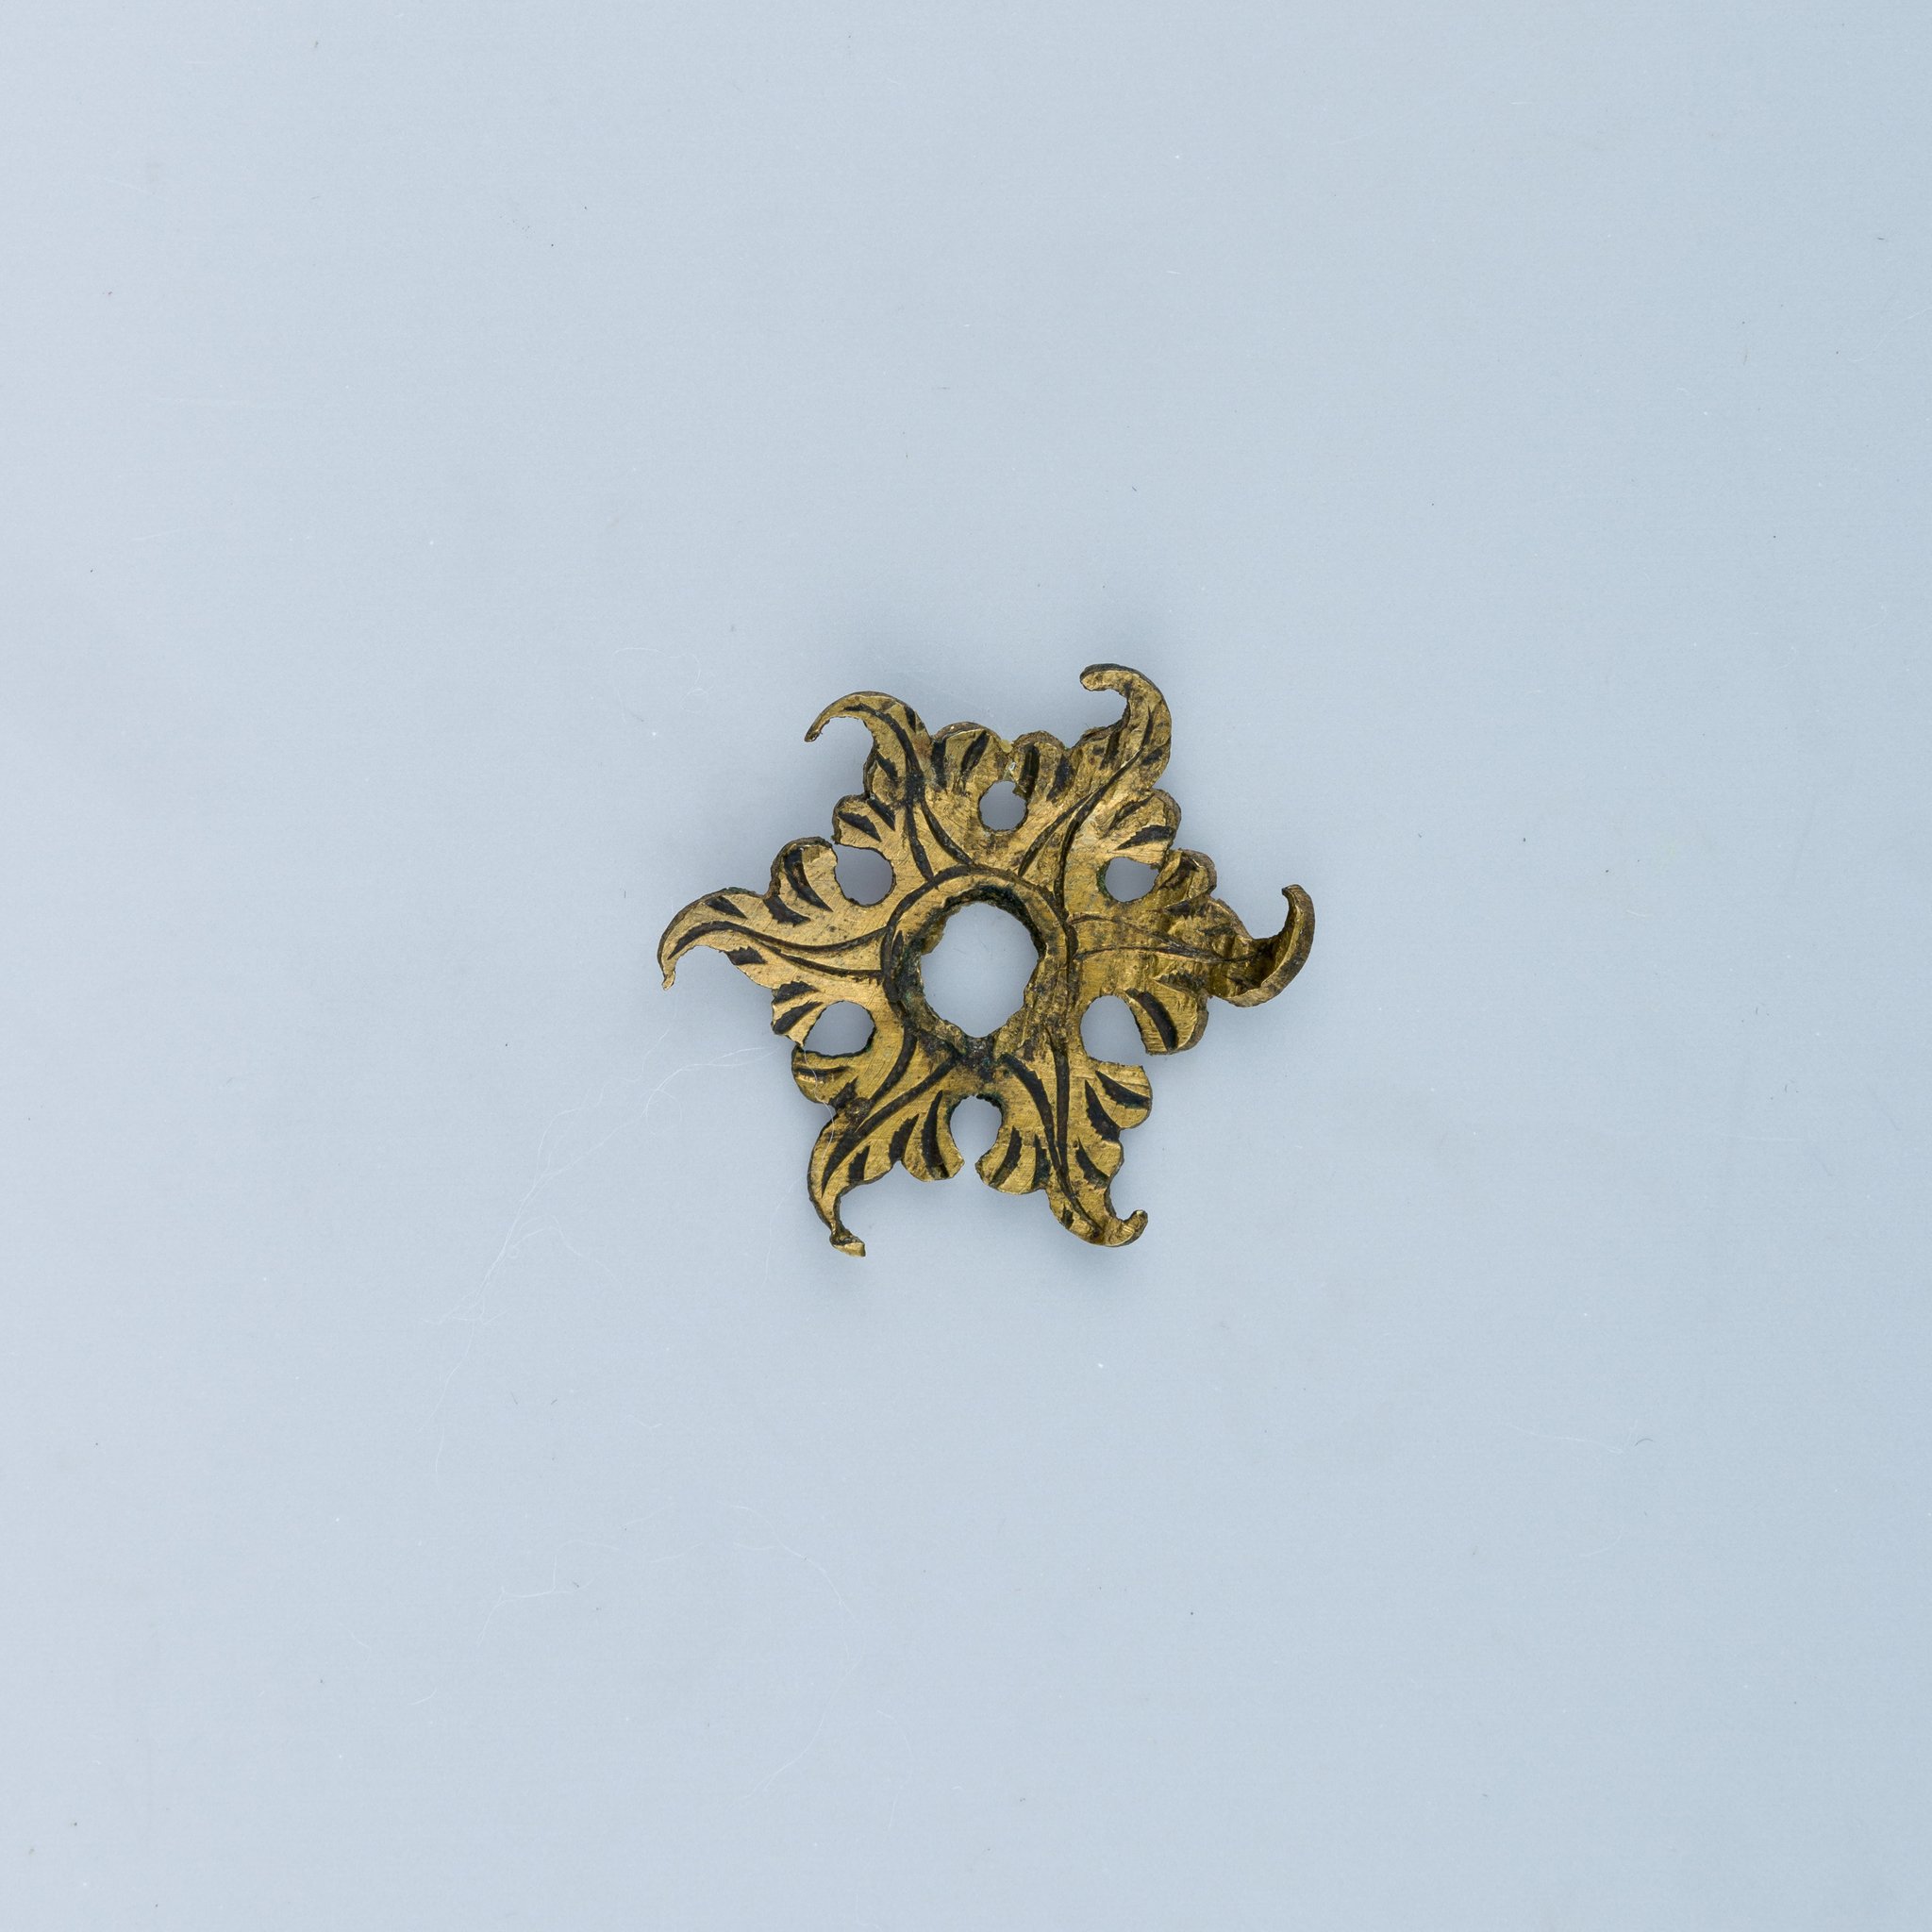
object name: rosette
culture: german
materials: brass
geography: germany